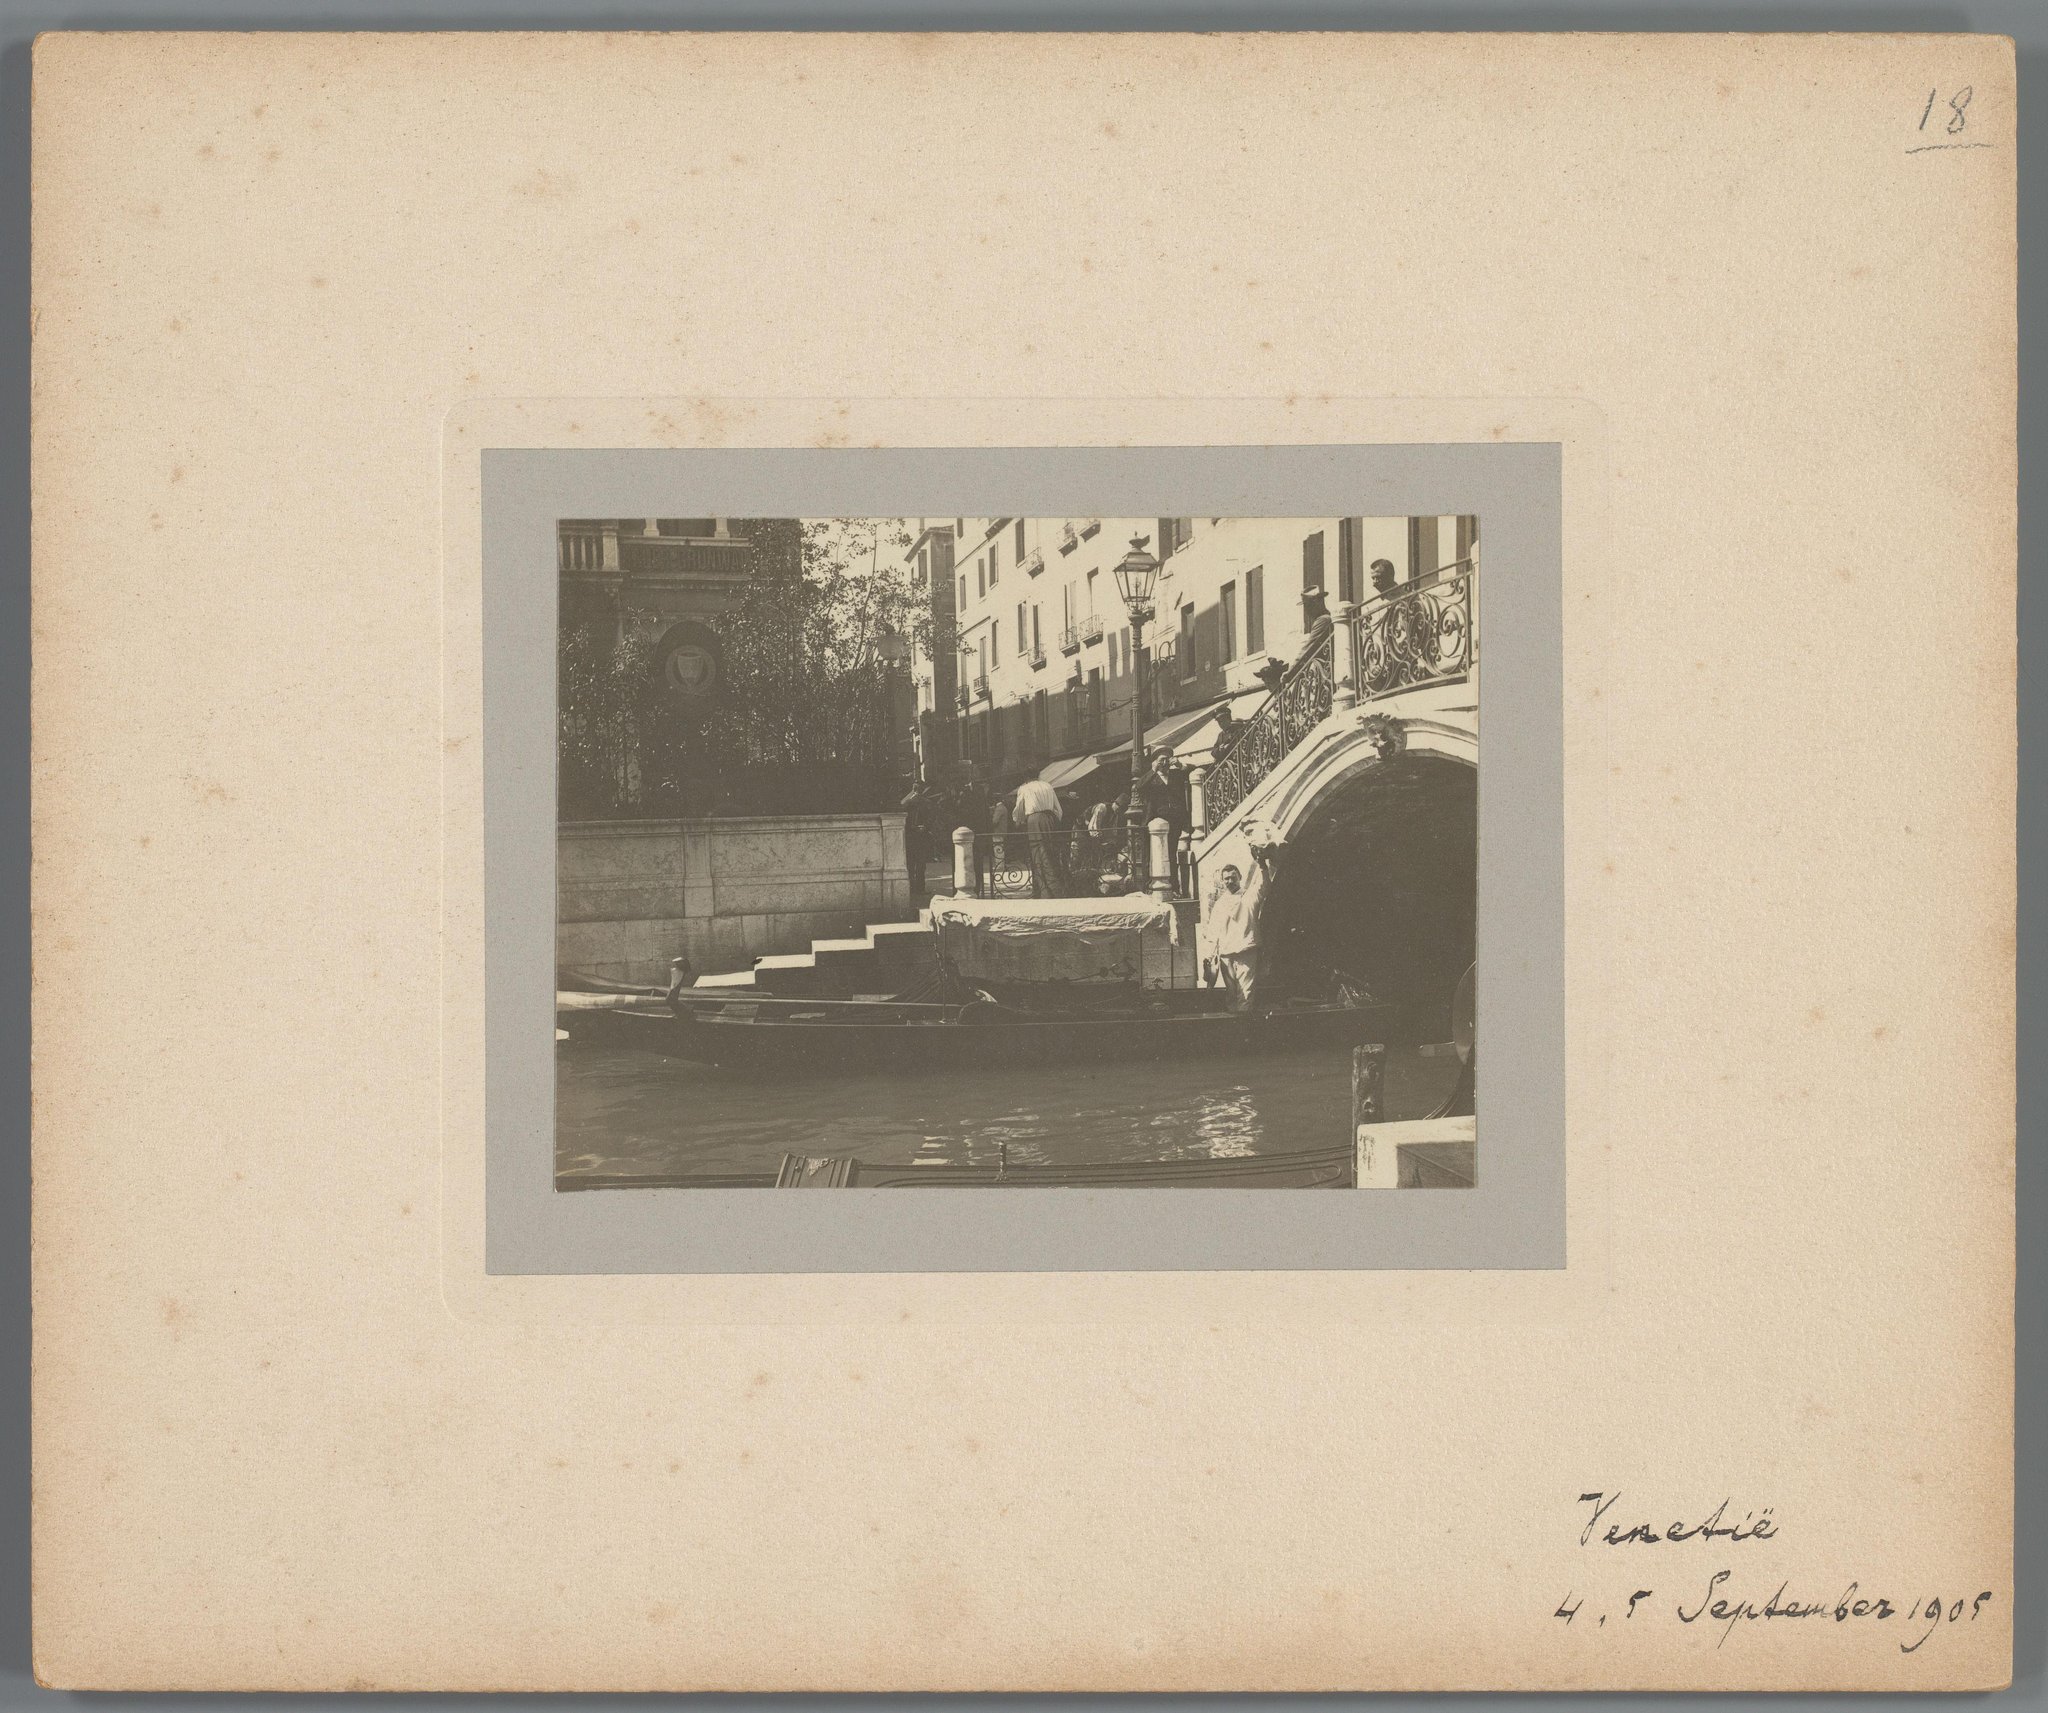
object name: photograph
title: Gondel in Venetië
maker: françois buys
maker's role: advocaat, amateurfotograaf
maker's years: 1871-1934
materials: paper, cardboard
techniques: gelatin silver print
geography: venice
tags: bridge in city across river, canal, etc., gondola, venice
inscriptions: number: ‘18’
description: Deze foto maakt deel uit van een groep van 38 foto's.